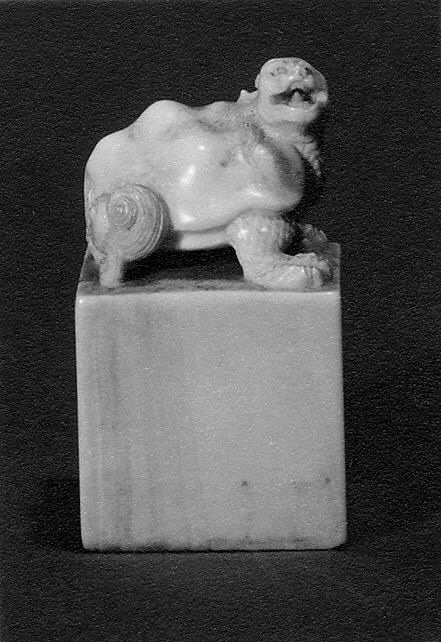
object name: seal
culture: chinese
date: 1701-1800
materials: ivory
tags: animals